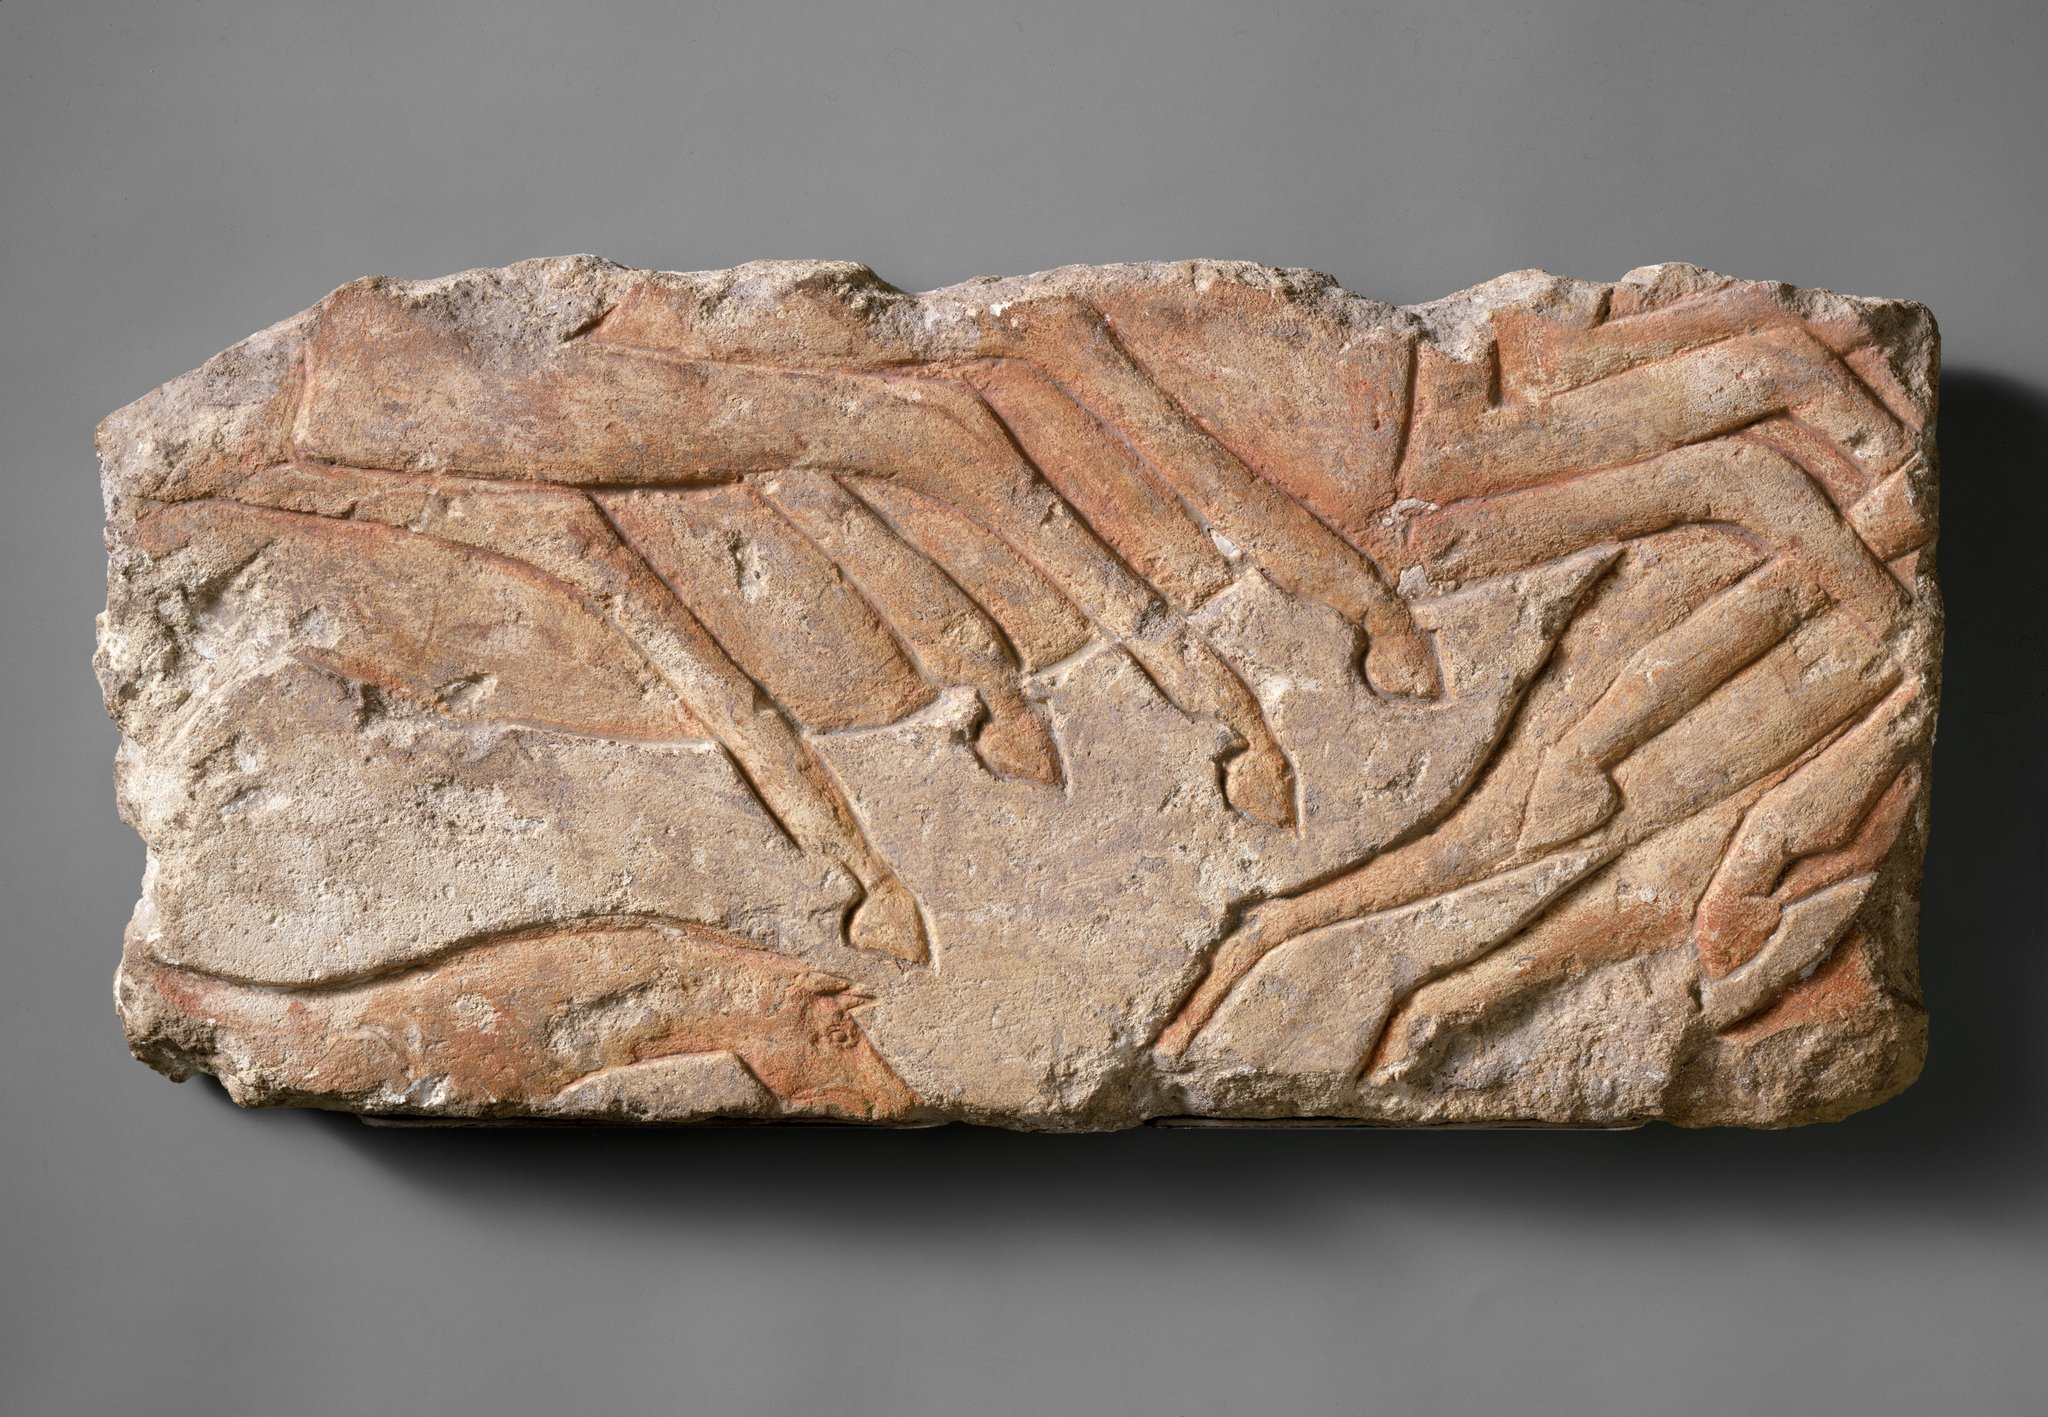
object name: talatat, horse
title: Galloping Horses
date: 1353-1336 BCE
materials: limestone, paint